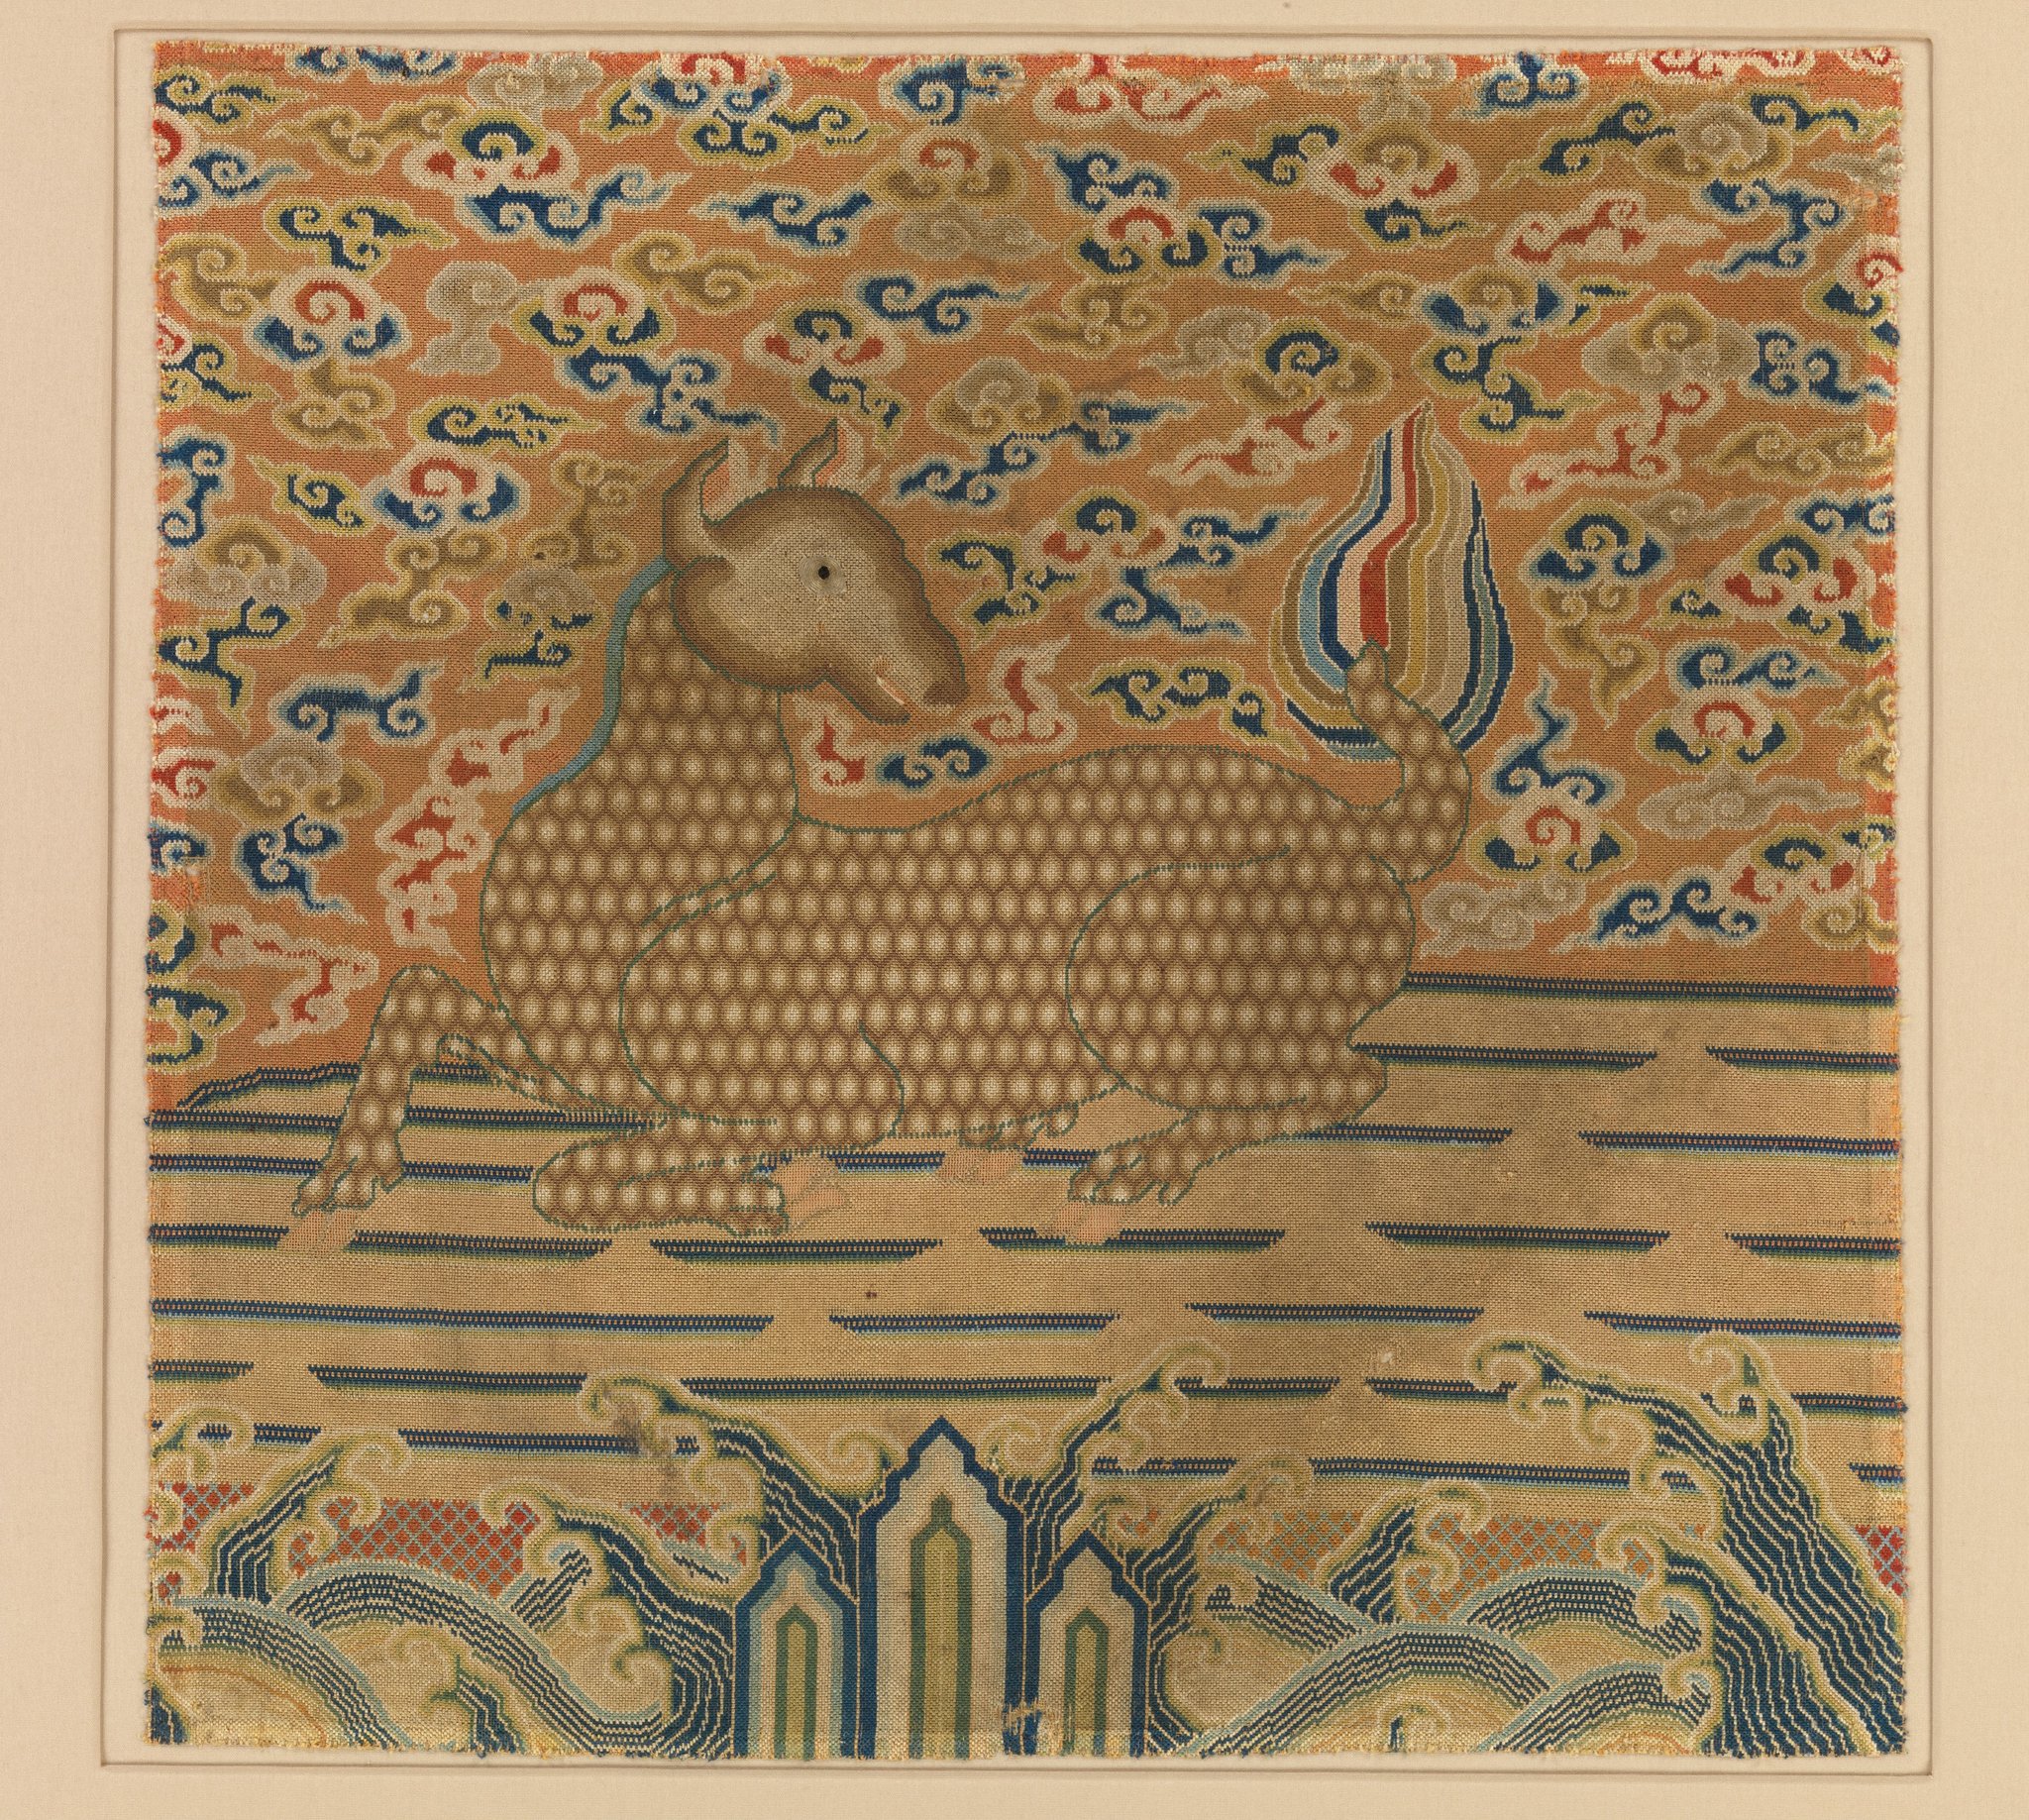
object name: scroll cover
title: Scroll Cover with Mythical Creature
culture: chinese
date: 1701-1800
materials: textile, silk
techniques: embroidery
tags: mythical creatures